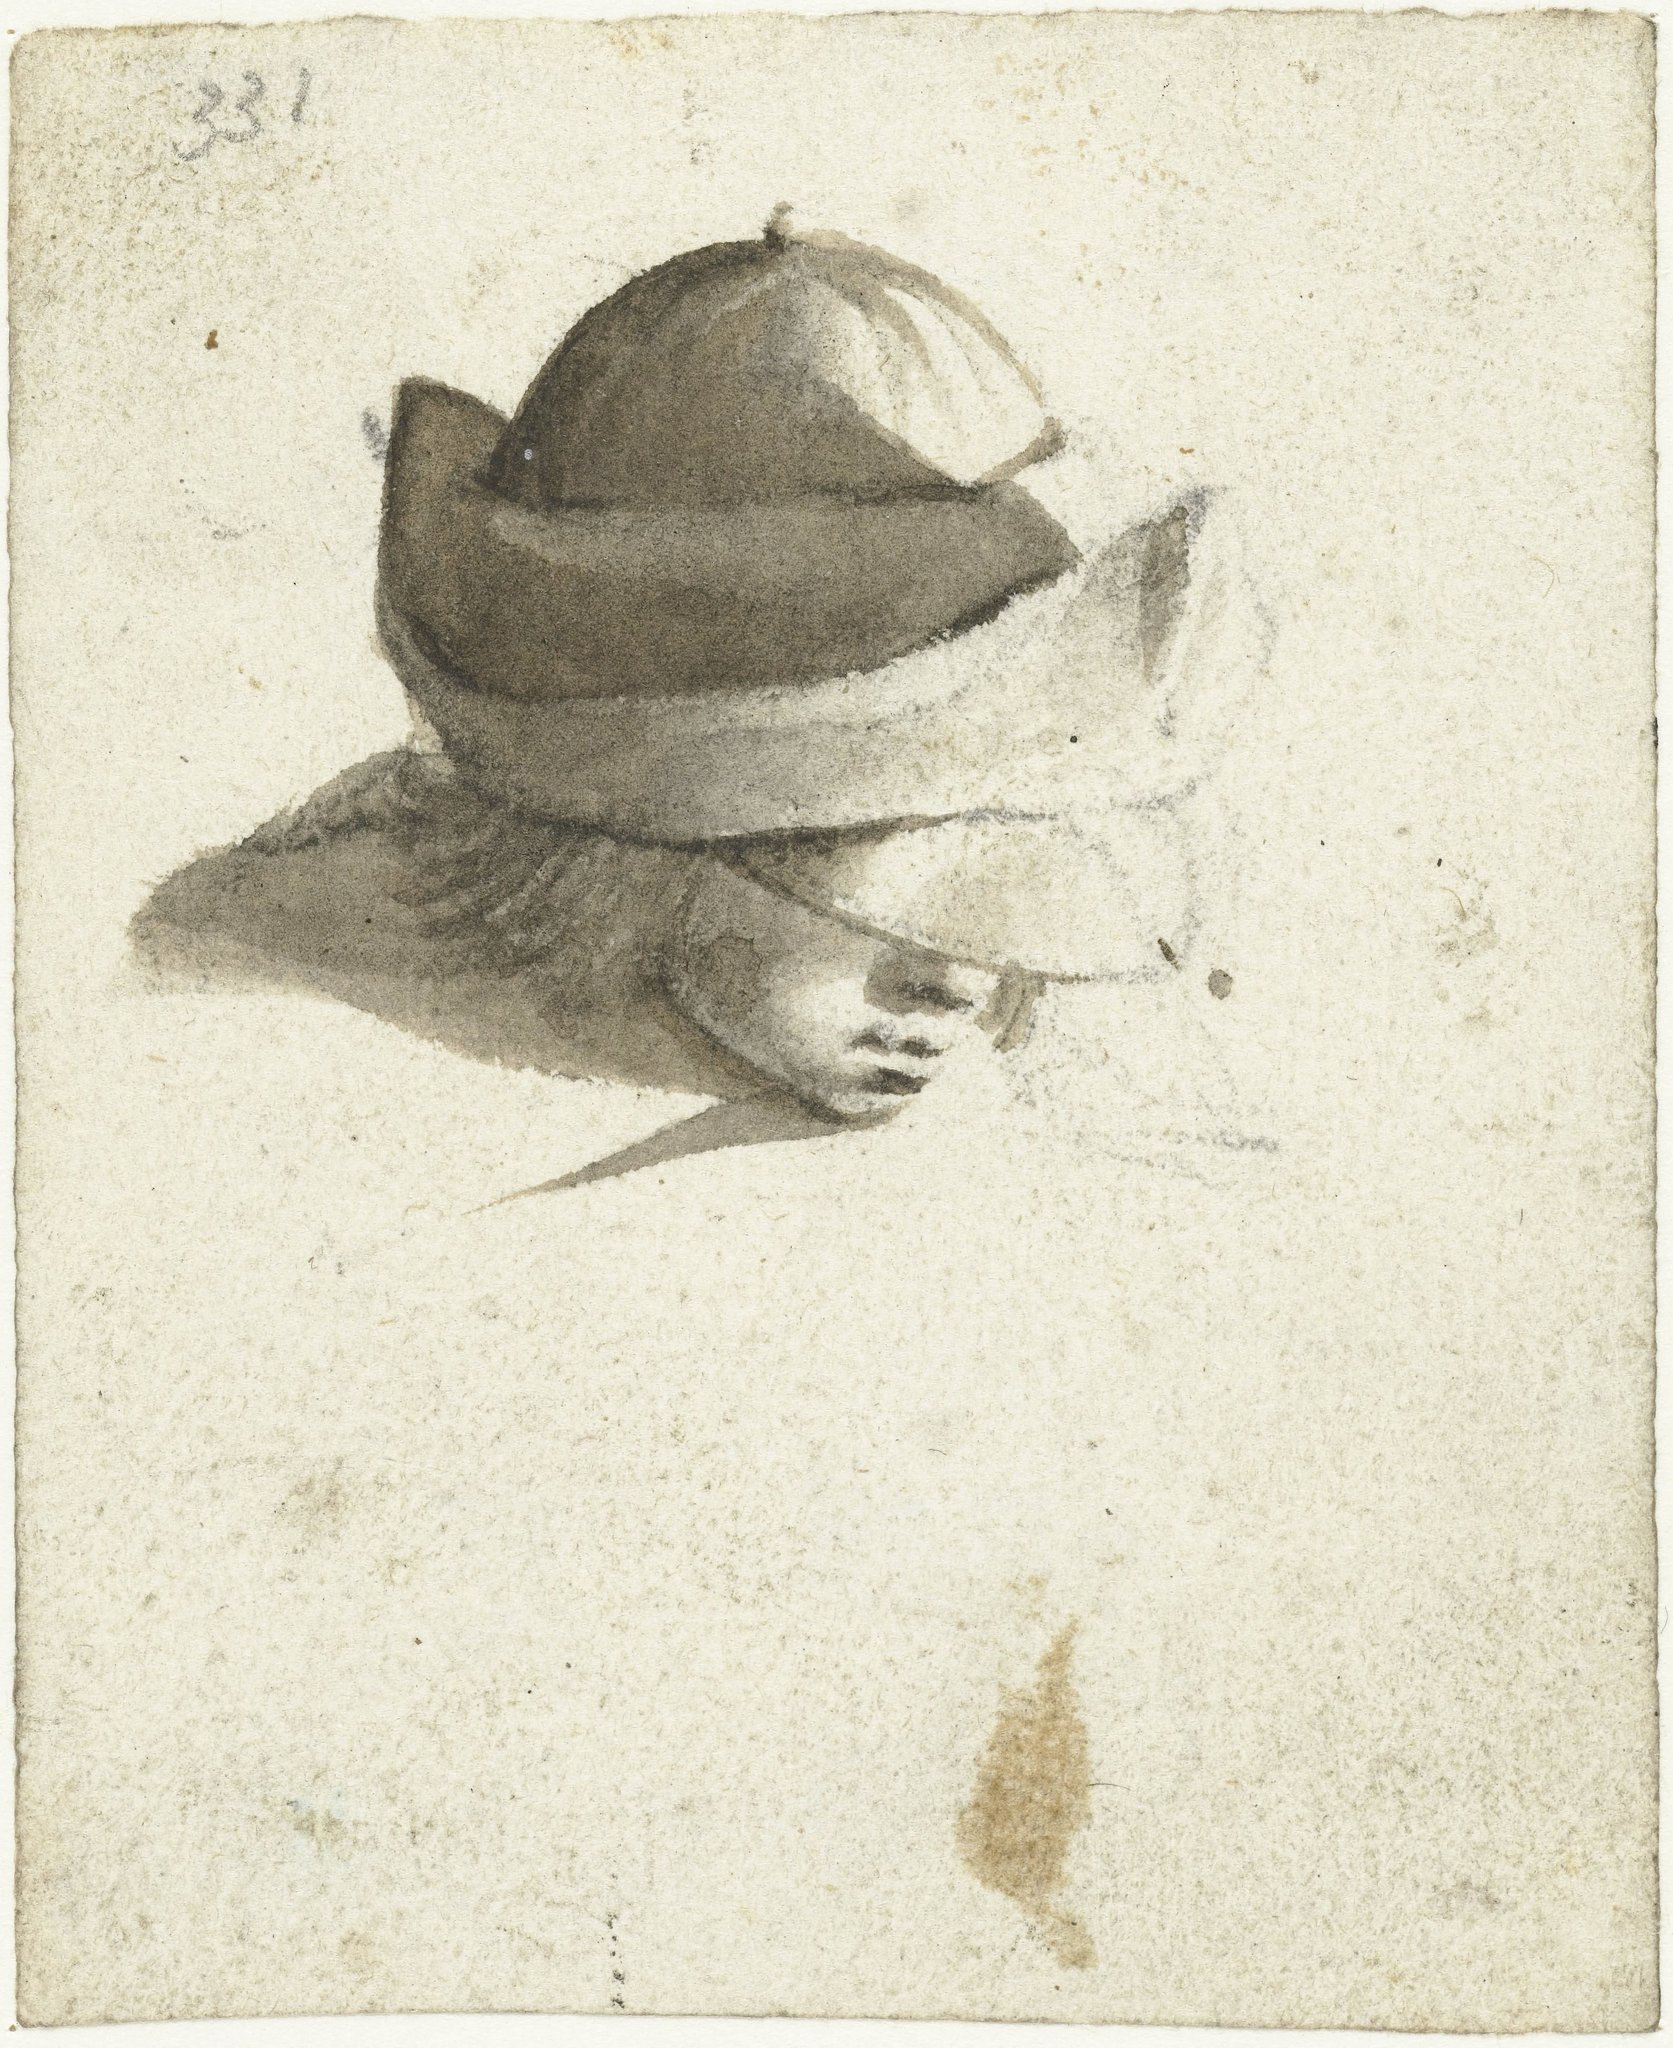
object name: drawing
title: Studieblad met kop van een jongetje, van bovenaf gezien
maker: gerard ter borch (ii)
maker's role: draughtsman, painter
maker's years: 1617-1681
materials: chalk, ink, paper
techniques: brush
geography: zwolle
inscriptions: annotation: ‘G. Ter Borch Sr. ; Ger Sr’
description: Tegelijkertijd met GJr 30 en 31 naar het leven getekend; misschien was een neefje of buurjongetje het model.